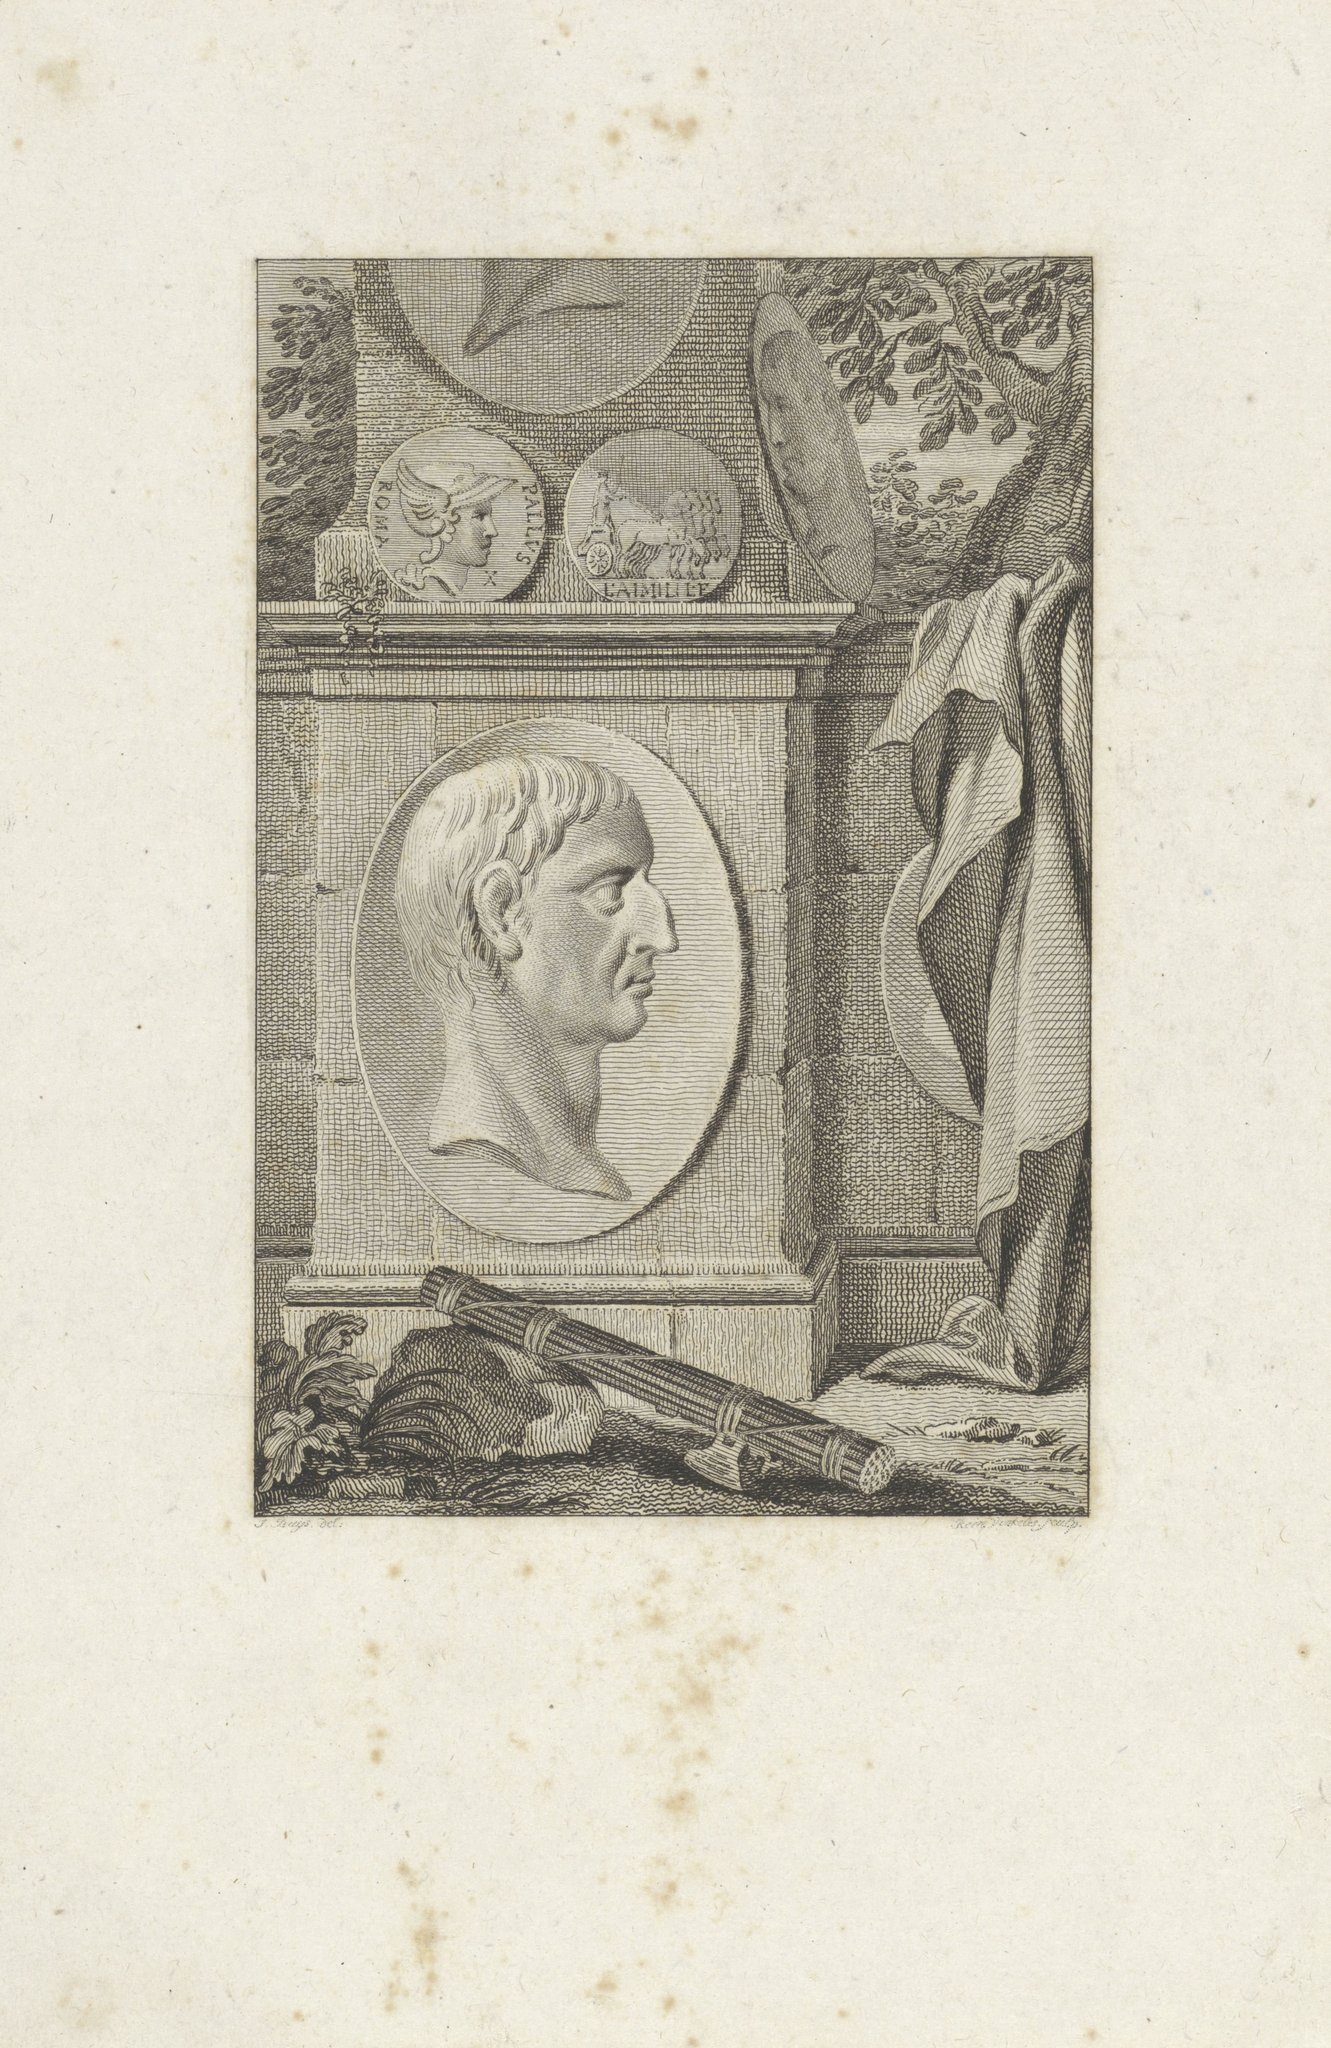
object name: print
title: Medaillon met het portret van Gaius Julius Caesar (?)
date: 1789-1809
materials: paper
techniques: etching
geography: amsterdam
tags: rome, symbols and allegories of law; 'legge', 'legge civile' (ripa) (+ 'fasces cum securibus'), base (~ column, pillar)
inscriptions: collector's mark: Lugt 240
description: Latere staat prent vermoedelijk ook gebruikt als boekillustratie in: Plutarchus [bewerkt door E. Wassenbergh en H. Bosscha]. De levens van doorluchtige Grieken en Romeinen, onderling vergeleeken (...). 12 dln. Amsterdam: Johannes Allart, 1789-1809.